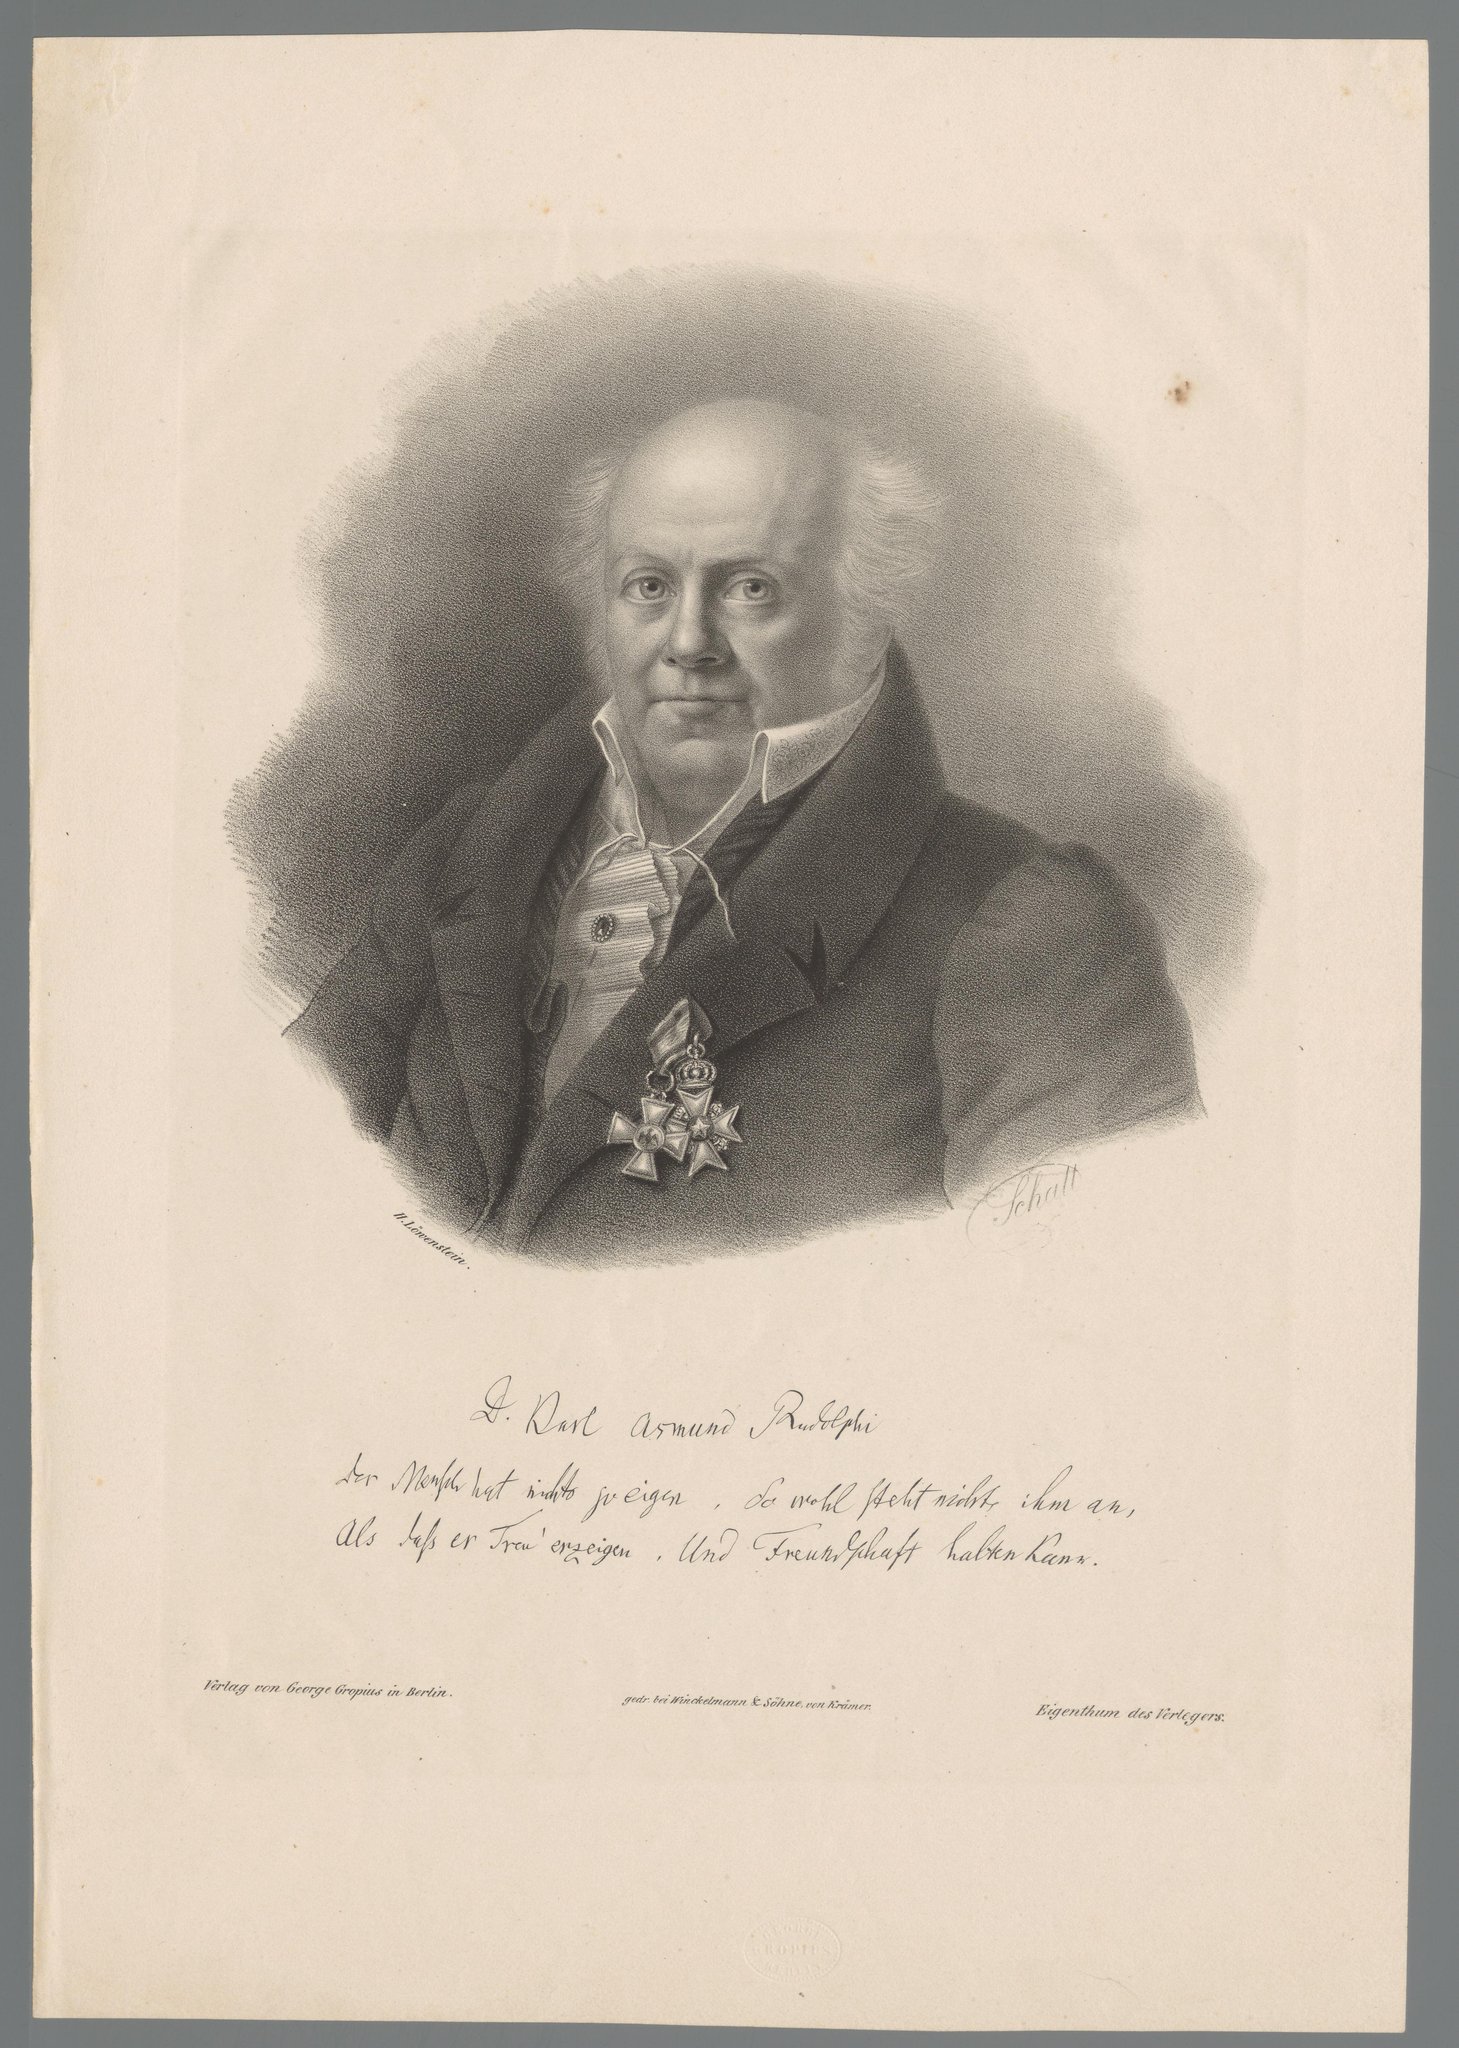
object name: print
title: Portret van Karl Asmund Rudolphi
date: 1820-1875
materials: paper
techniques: lithograph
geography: berlin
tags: adult man, historical persons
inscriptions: collector's mark: Lugt 2228, check stamp: Lugt 4607